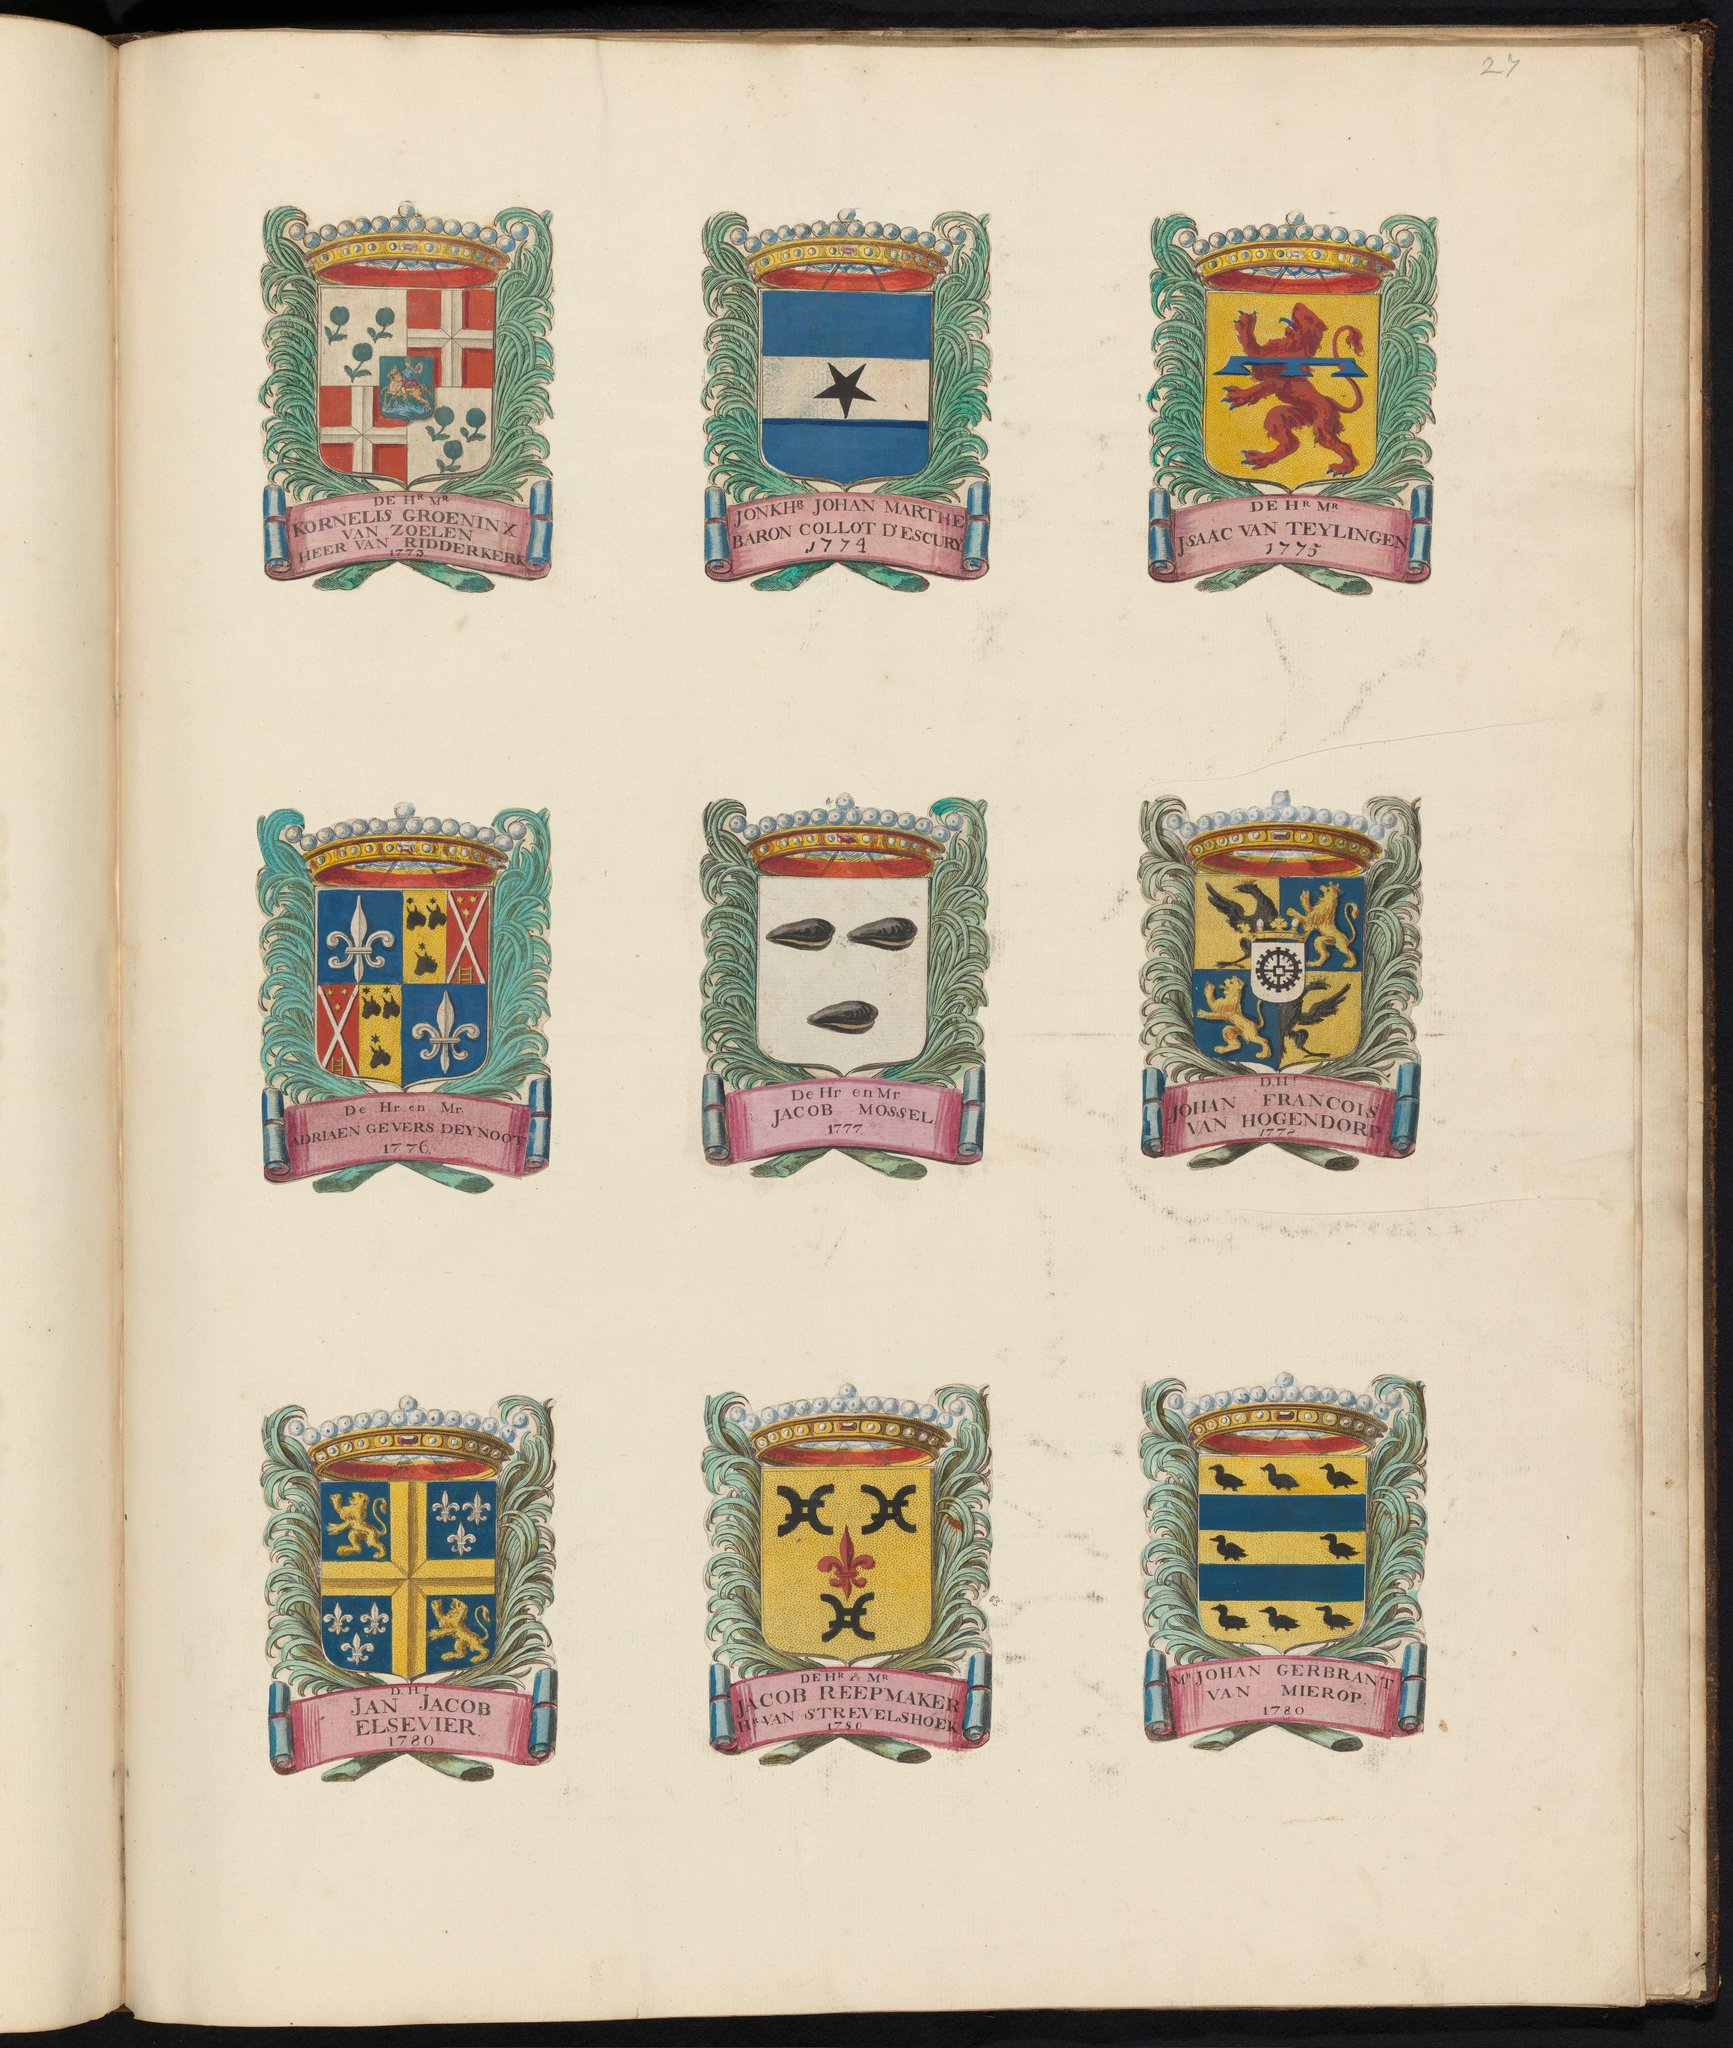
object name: album leaf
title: Negen wapens van raden in de vroedschap van Rotterdam, rechtsboven het wapen van Isaac van Teylingen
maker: Anonymous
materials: paper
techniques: colour, etching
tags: coat of arms (as symbol of the state, etc.), rotterdam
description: Negen voorstellingen op een albumblad. Het betreft negen wapen van raden in de vroedschap van Rotterdam. De prenten zijn onderdeel van de kaart van Rotterdam door Johannes de Vouw en maken deel uit van een album.